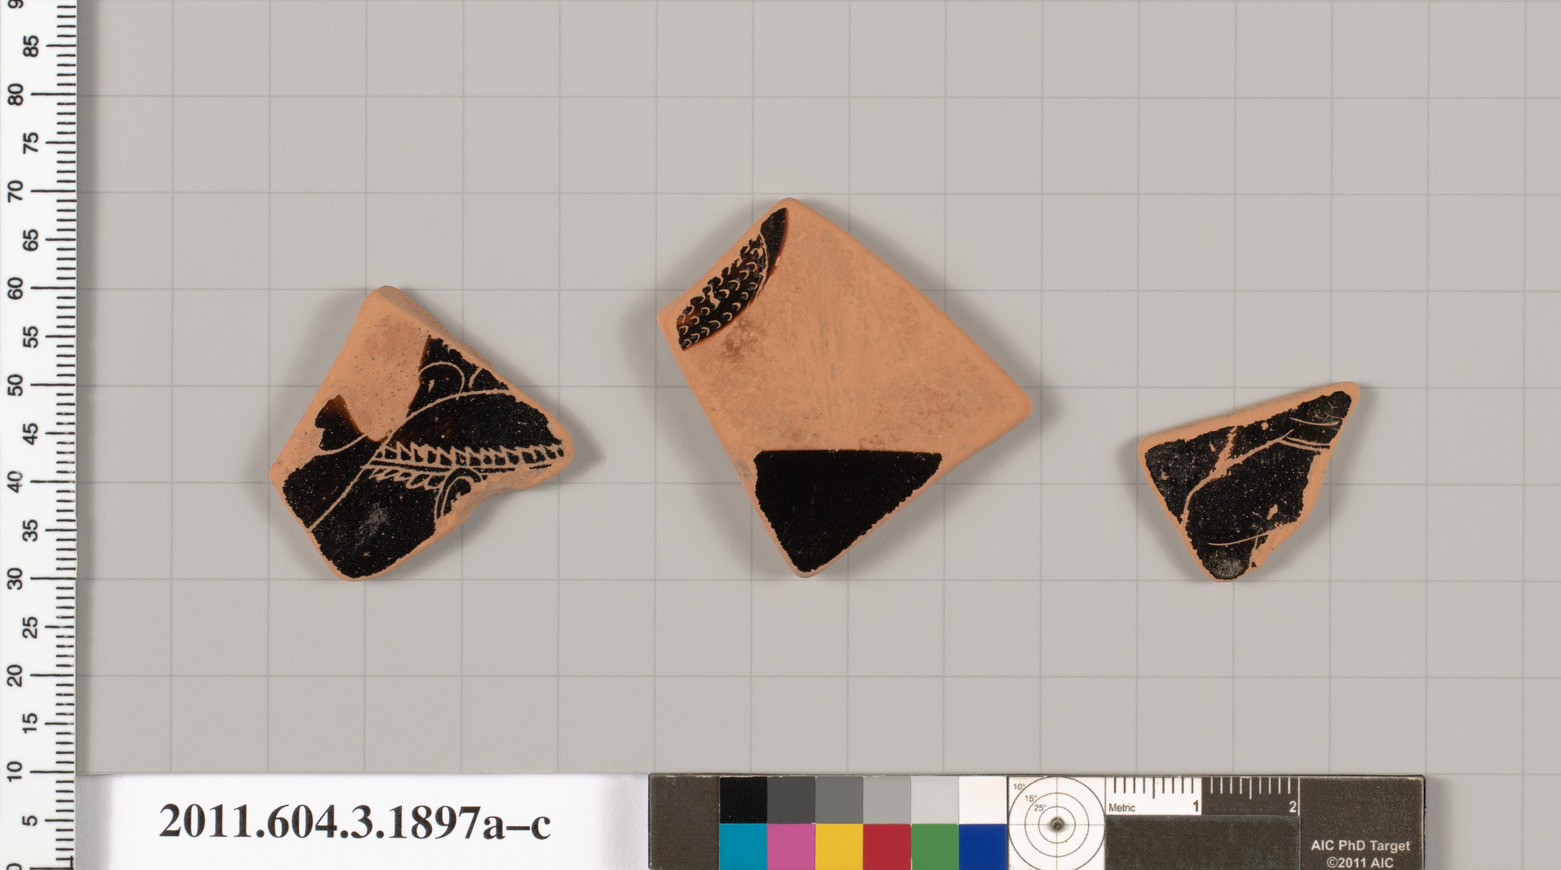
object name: undetermined open shape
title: Terracotta fragments of an open shape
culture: greek, attic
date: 525-501 BCE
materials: terracotta